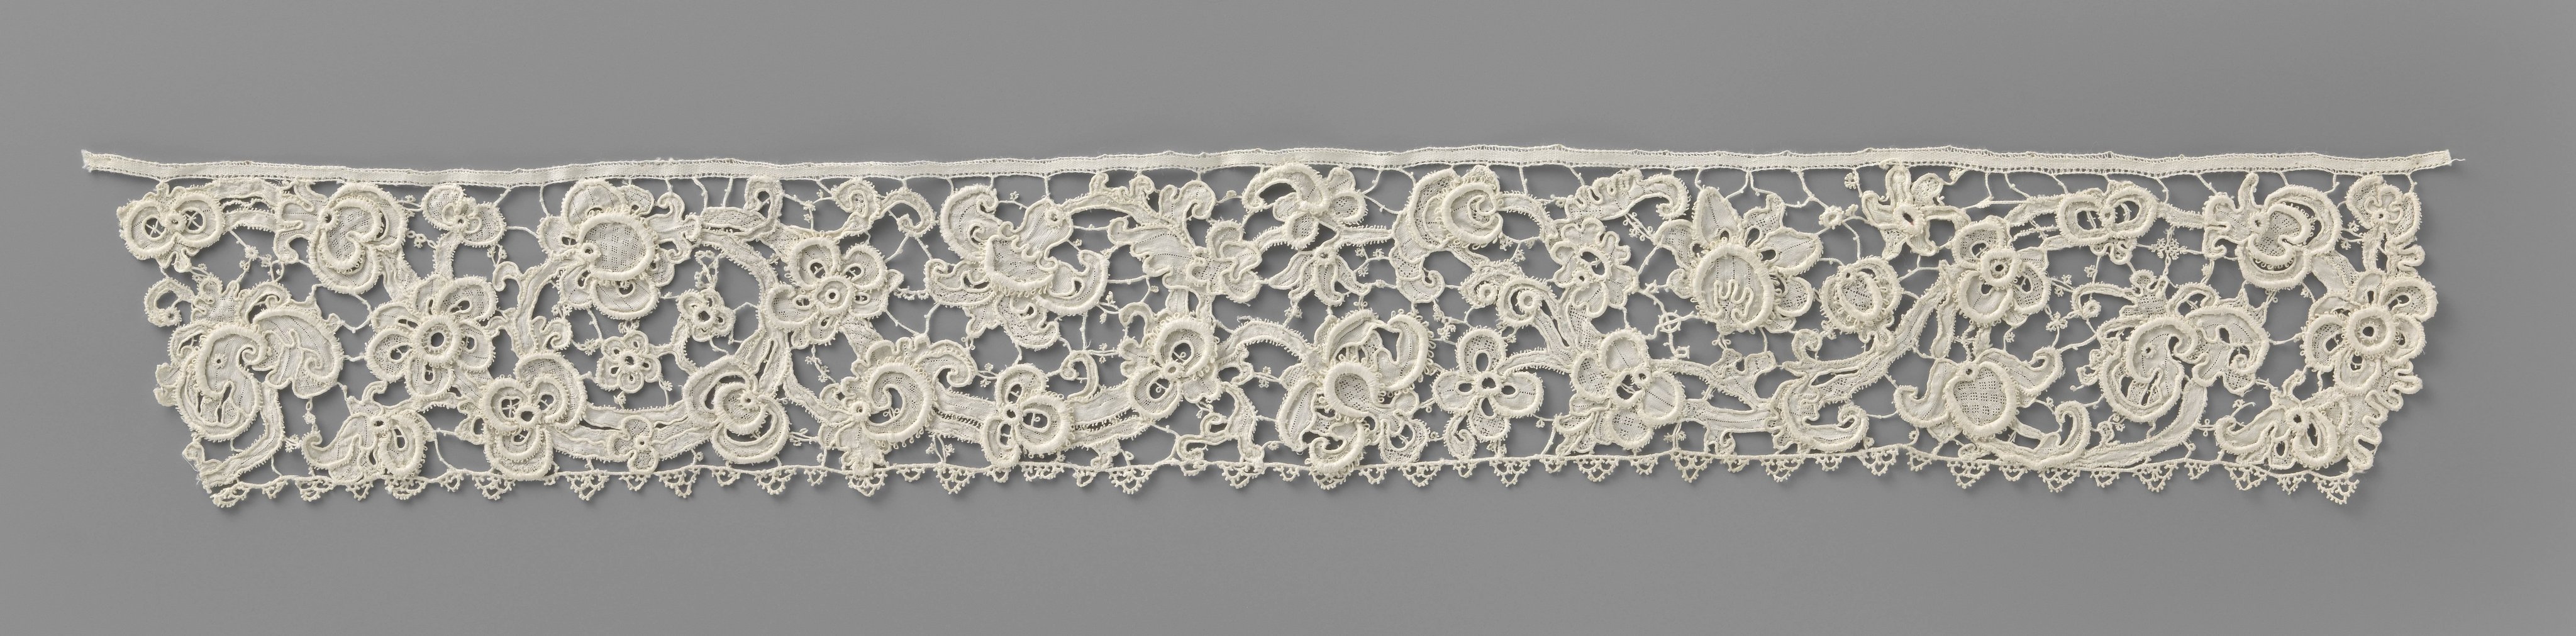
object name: strip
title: Strook naaldkant met gespleten spiralen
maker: Anonymous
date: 1800-1899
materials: linen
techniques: embroidery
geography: bayeux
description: Manchet van naturelkleurige naaldkant: Venetiaanse reliëfkant. Op een open spijlengrond staan lopende, brede spiraalranken, die op vele plaatsen zijn gespleten. Ook in de bloembladeren komen grote opengewerkte centra voor, hetgeen de 19de eeuw typeert. Afwerking met een recht lijst van om en om grote en kleine driehoekjes.